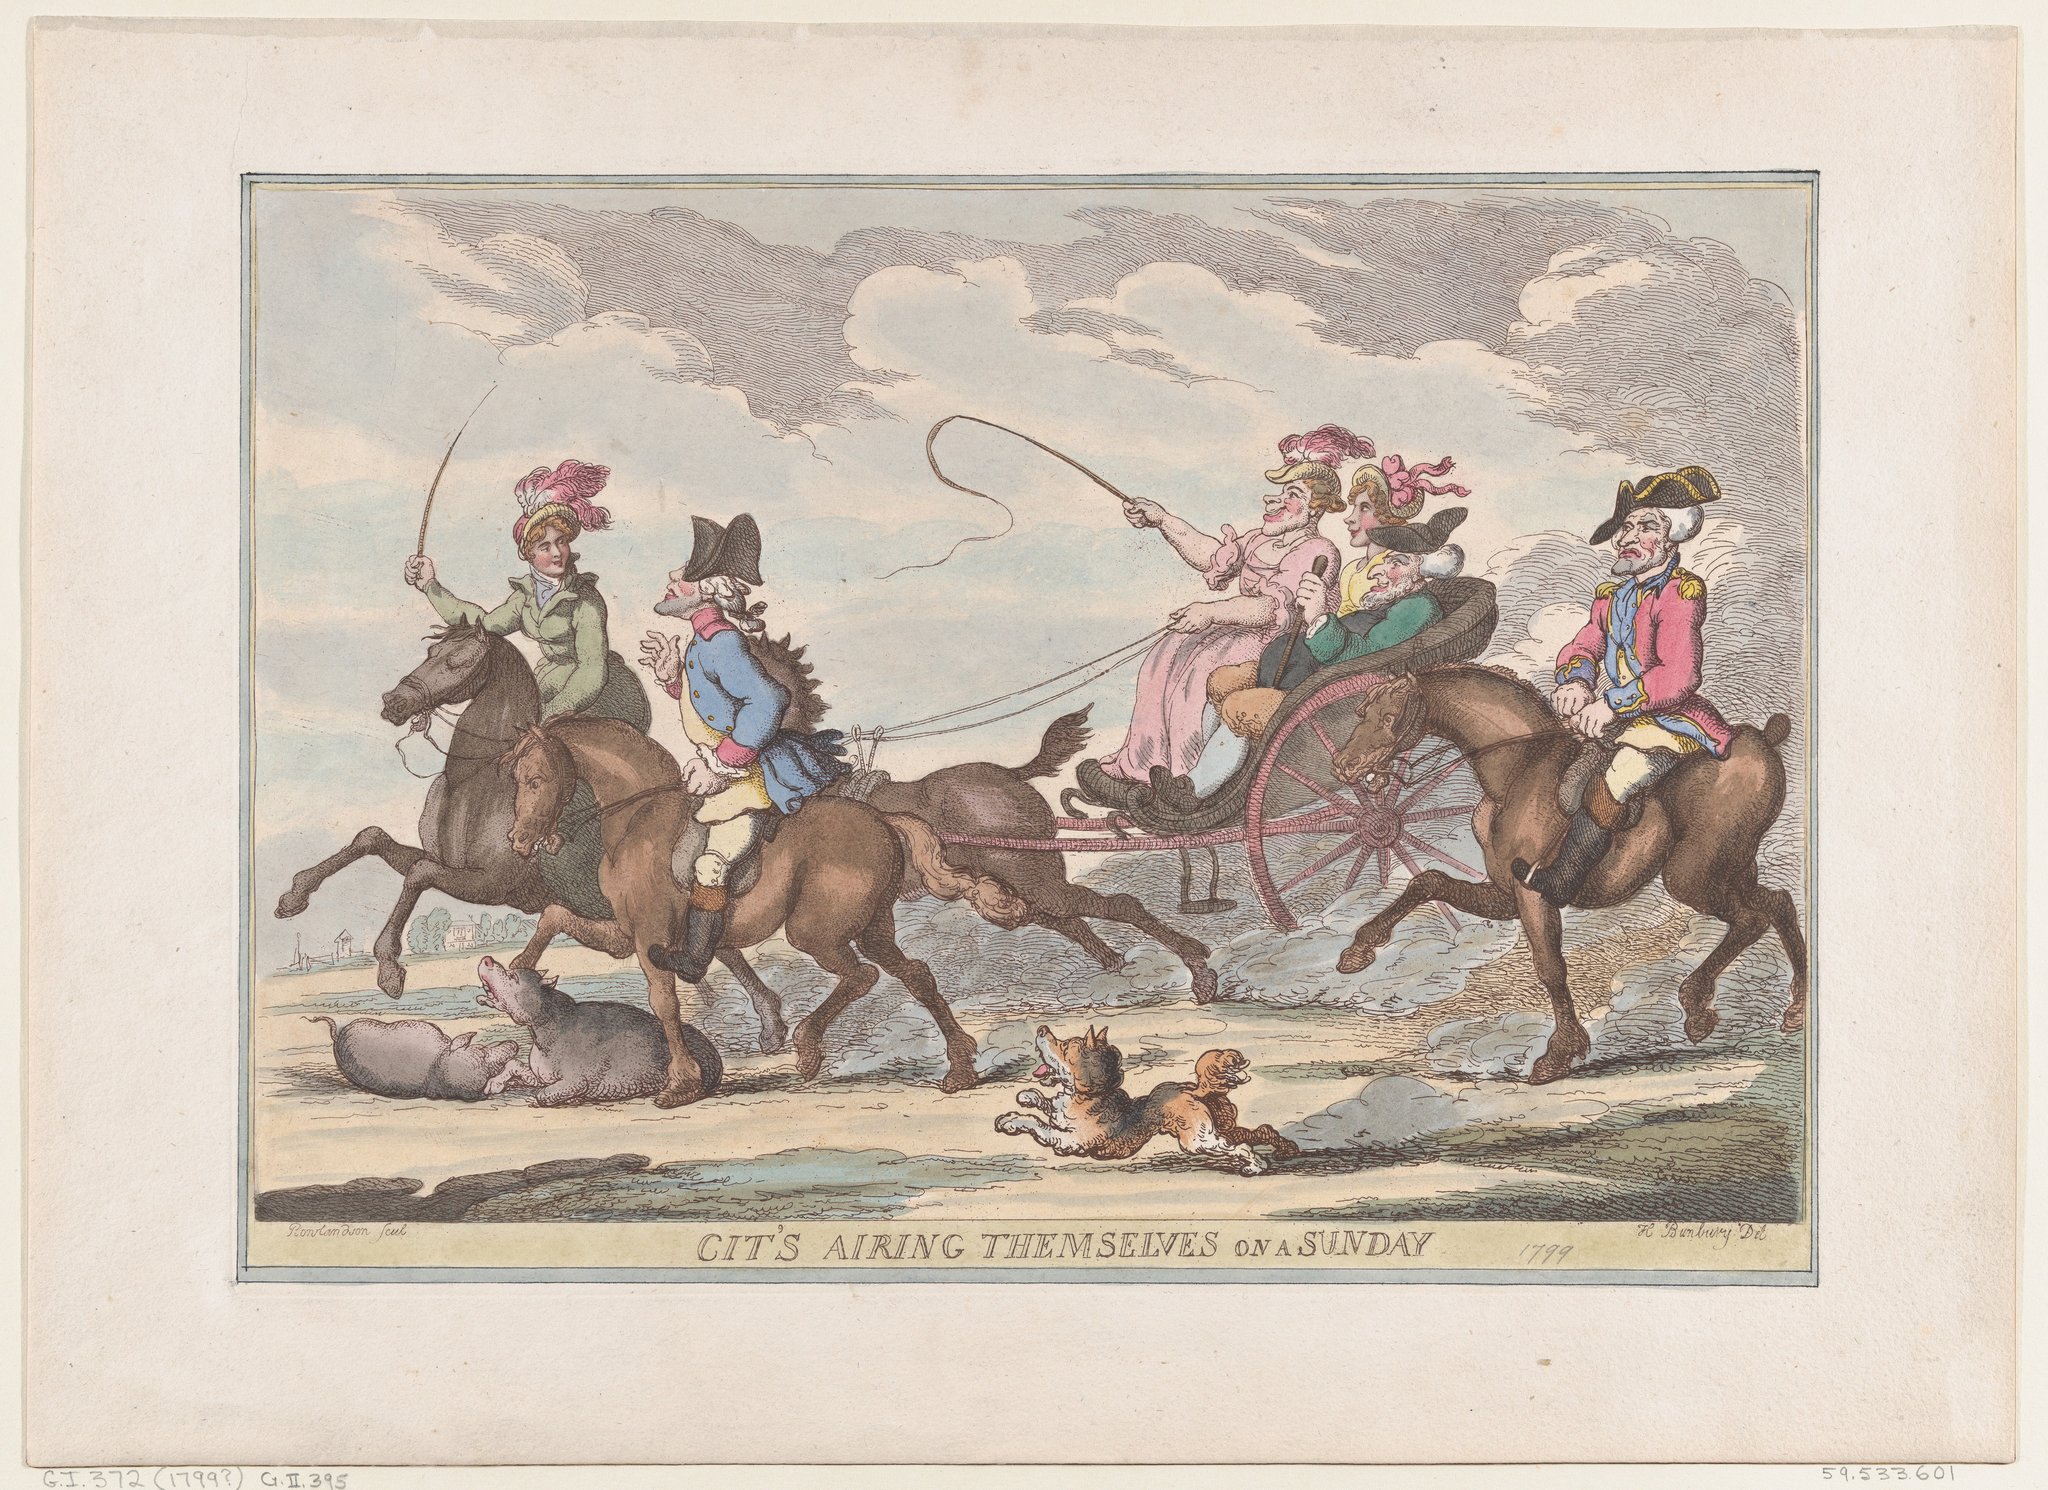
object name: print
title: Cit's Airing Themselves On A Sunday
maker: thomas rowlandson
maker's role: artist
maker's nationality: british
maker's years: 1757-1827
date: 1799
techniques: etching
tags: satire,men,women,dogs,horses,carriages